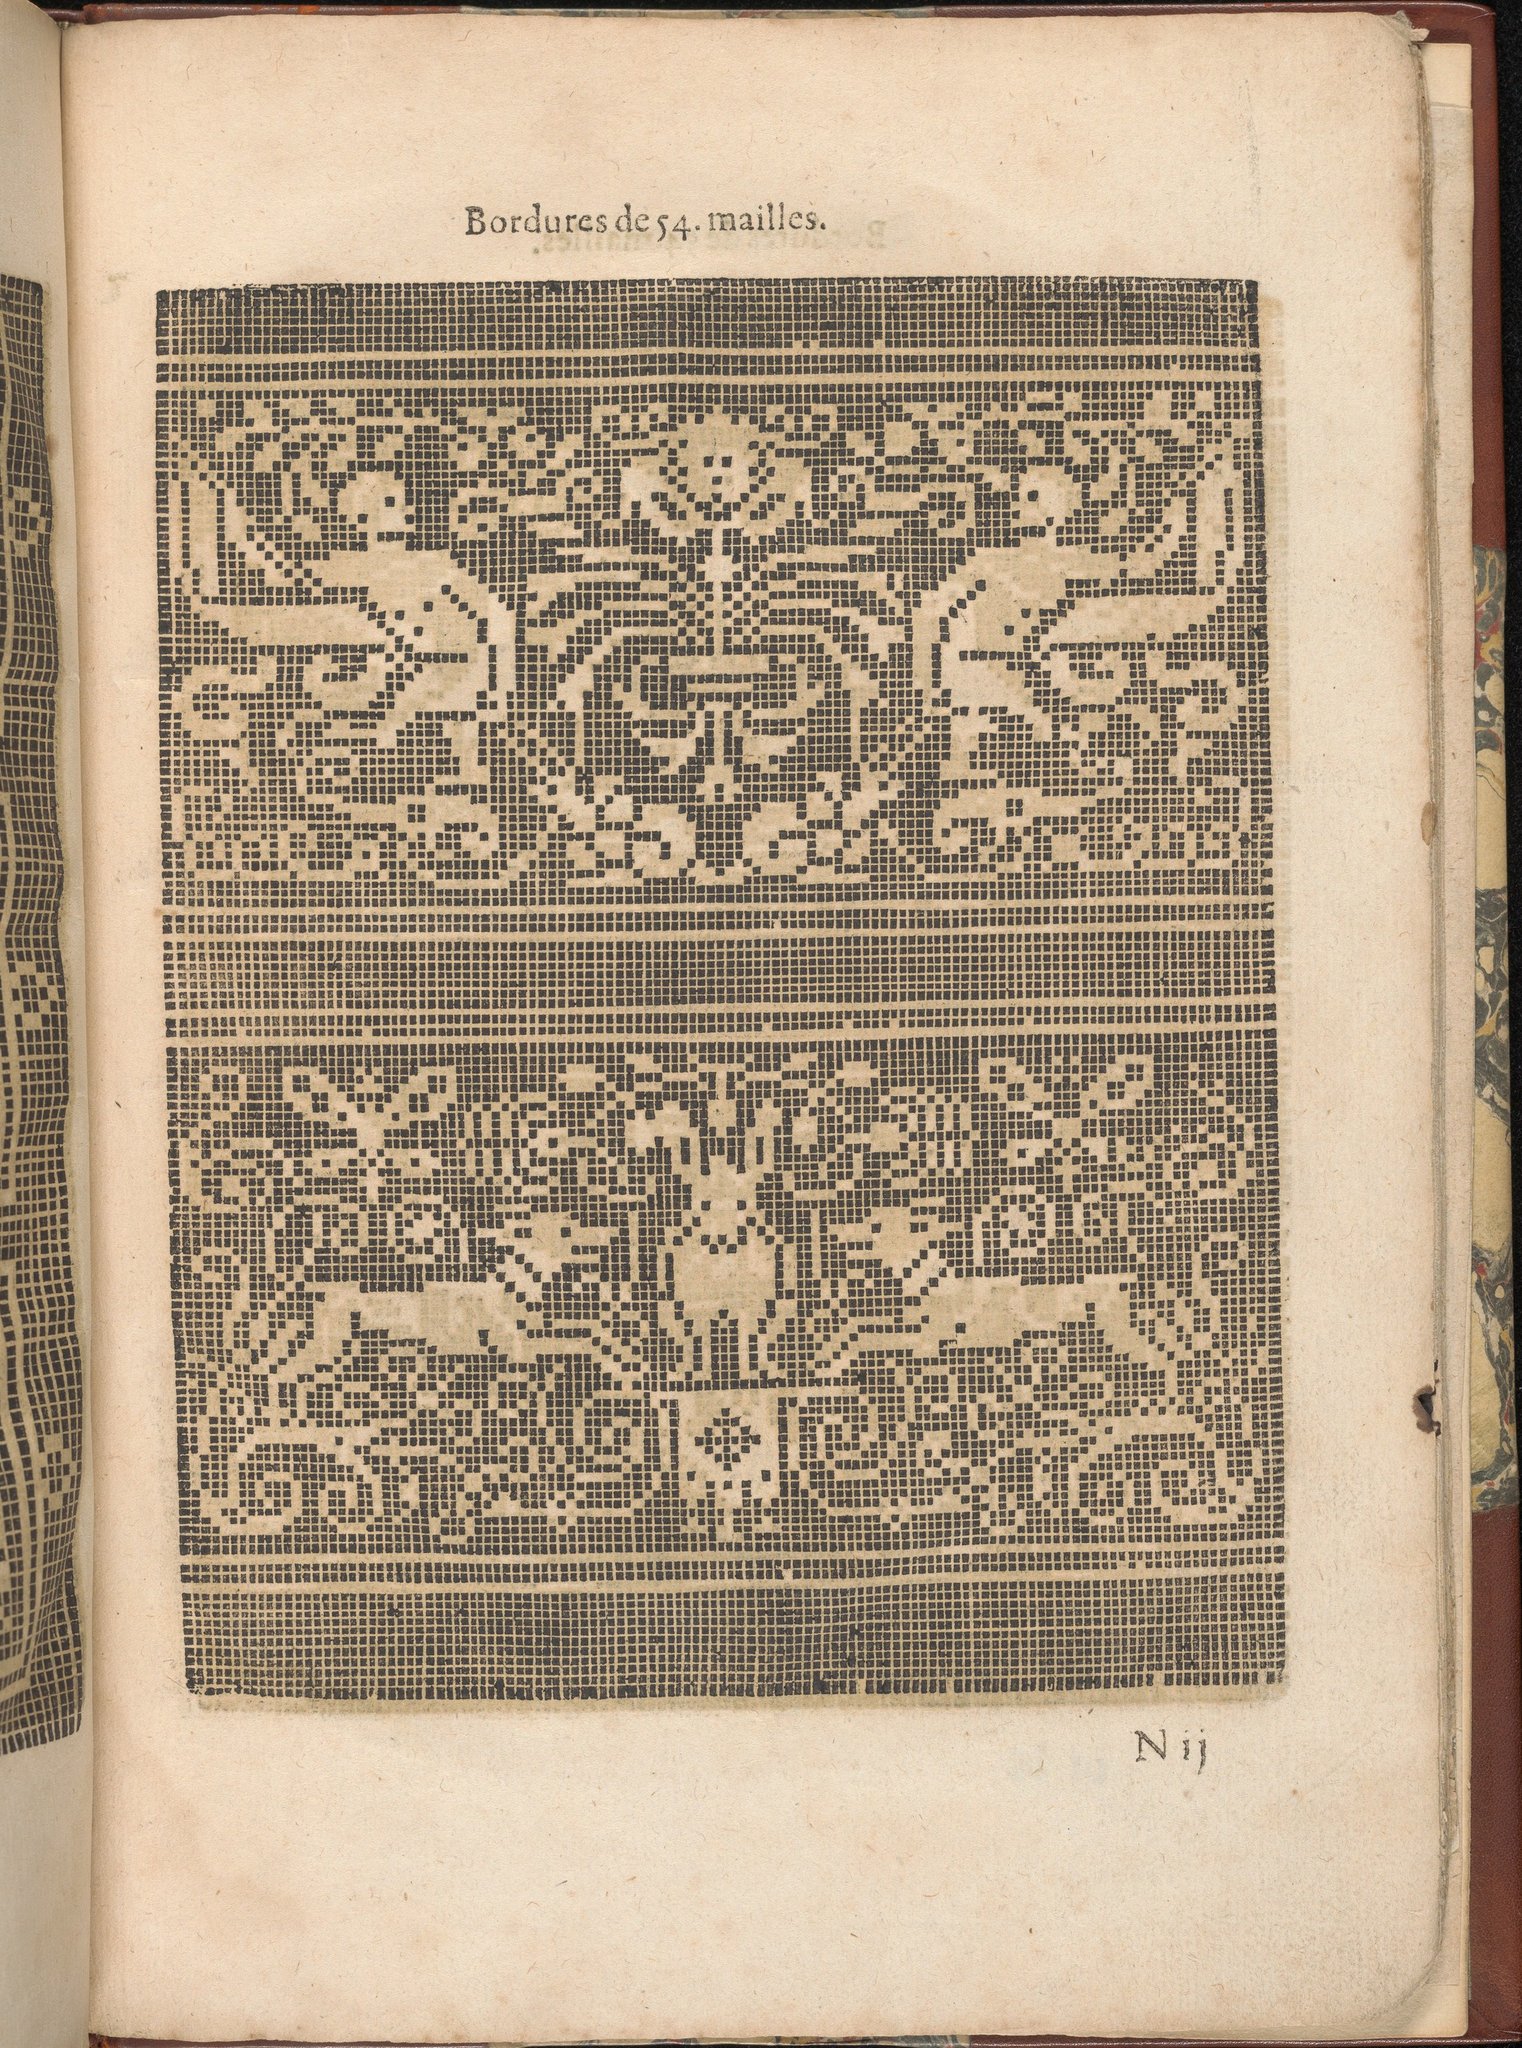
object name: book print ornament architecture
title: Les Secondes Oeuvres, et Subtiles Inventions De Lingerie du Seigneur Federic de Vinciolo Venitien, page 50 (recto)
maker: federico de vinciolo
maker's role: designer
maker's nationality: italian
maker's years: 1582-1599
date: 1603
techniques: woodcut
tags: human figures,heads,dogs,butterflies,rabbits,flowers,vines